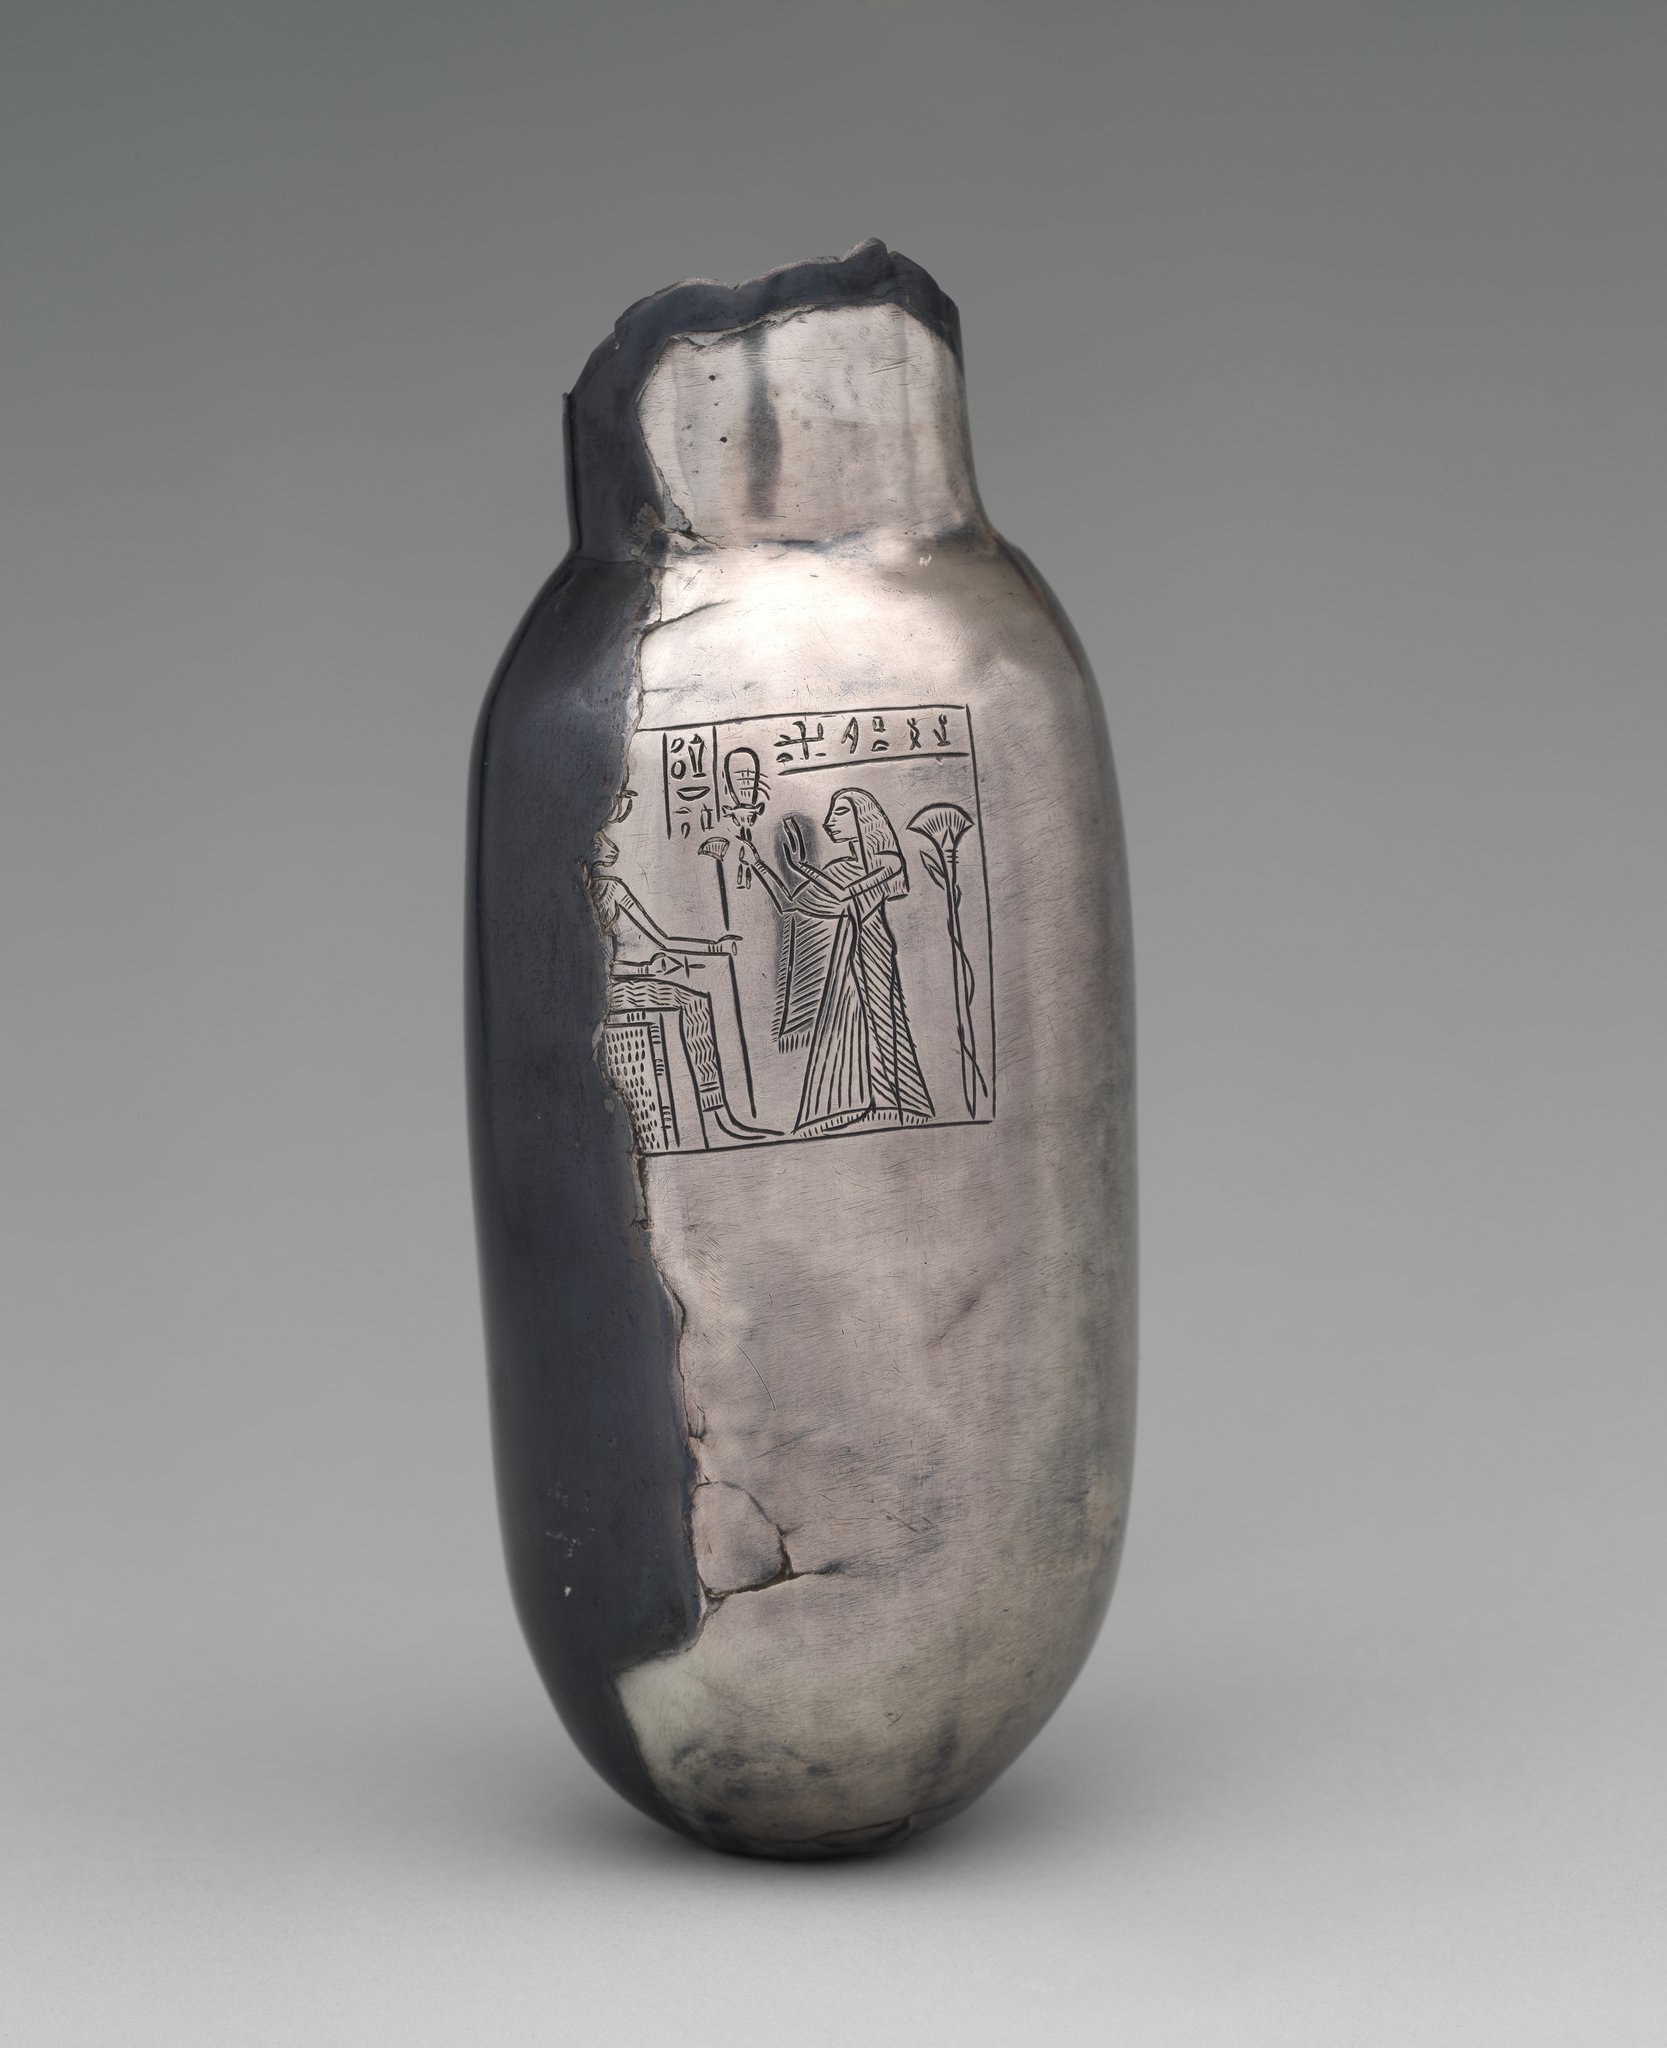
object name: jar, offering scene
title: Bottle illustrating Meritptah honoring Bastet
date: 1279-1213 BCE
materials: silver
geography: egypt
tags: women,hieroglyphs